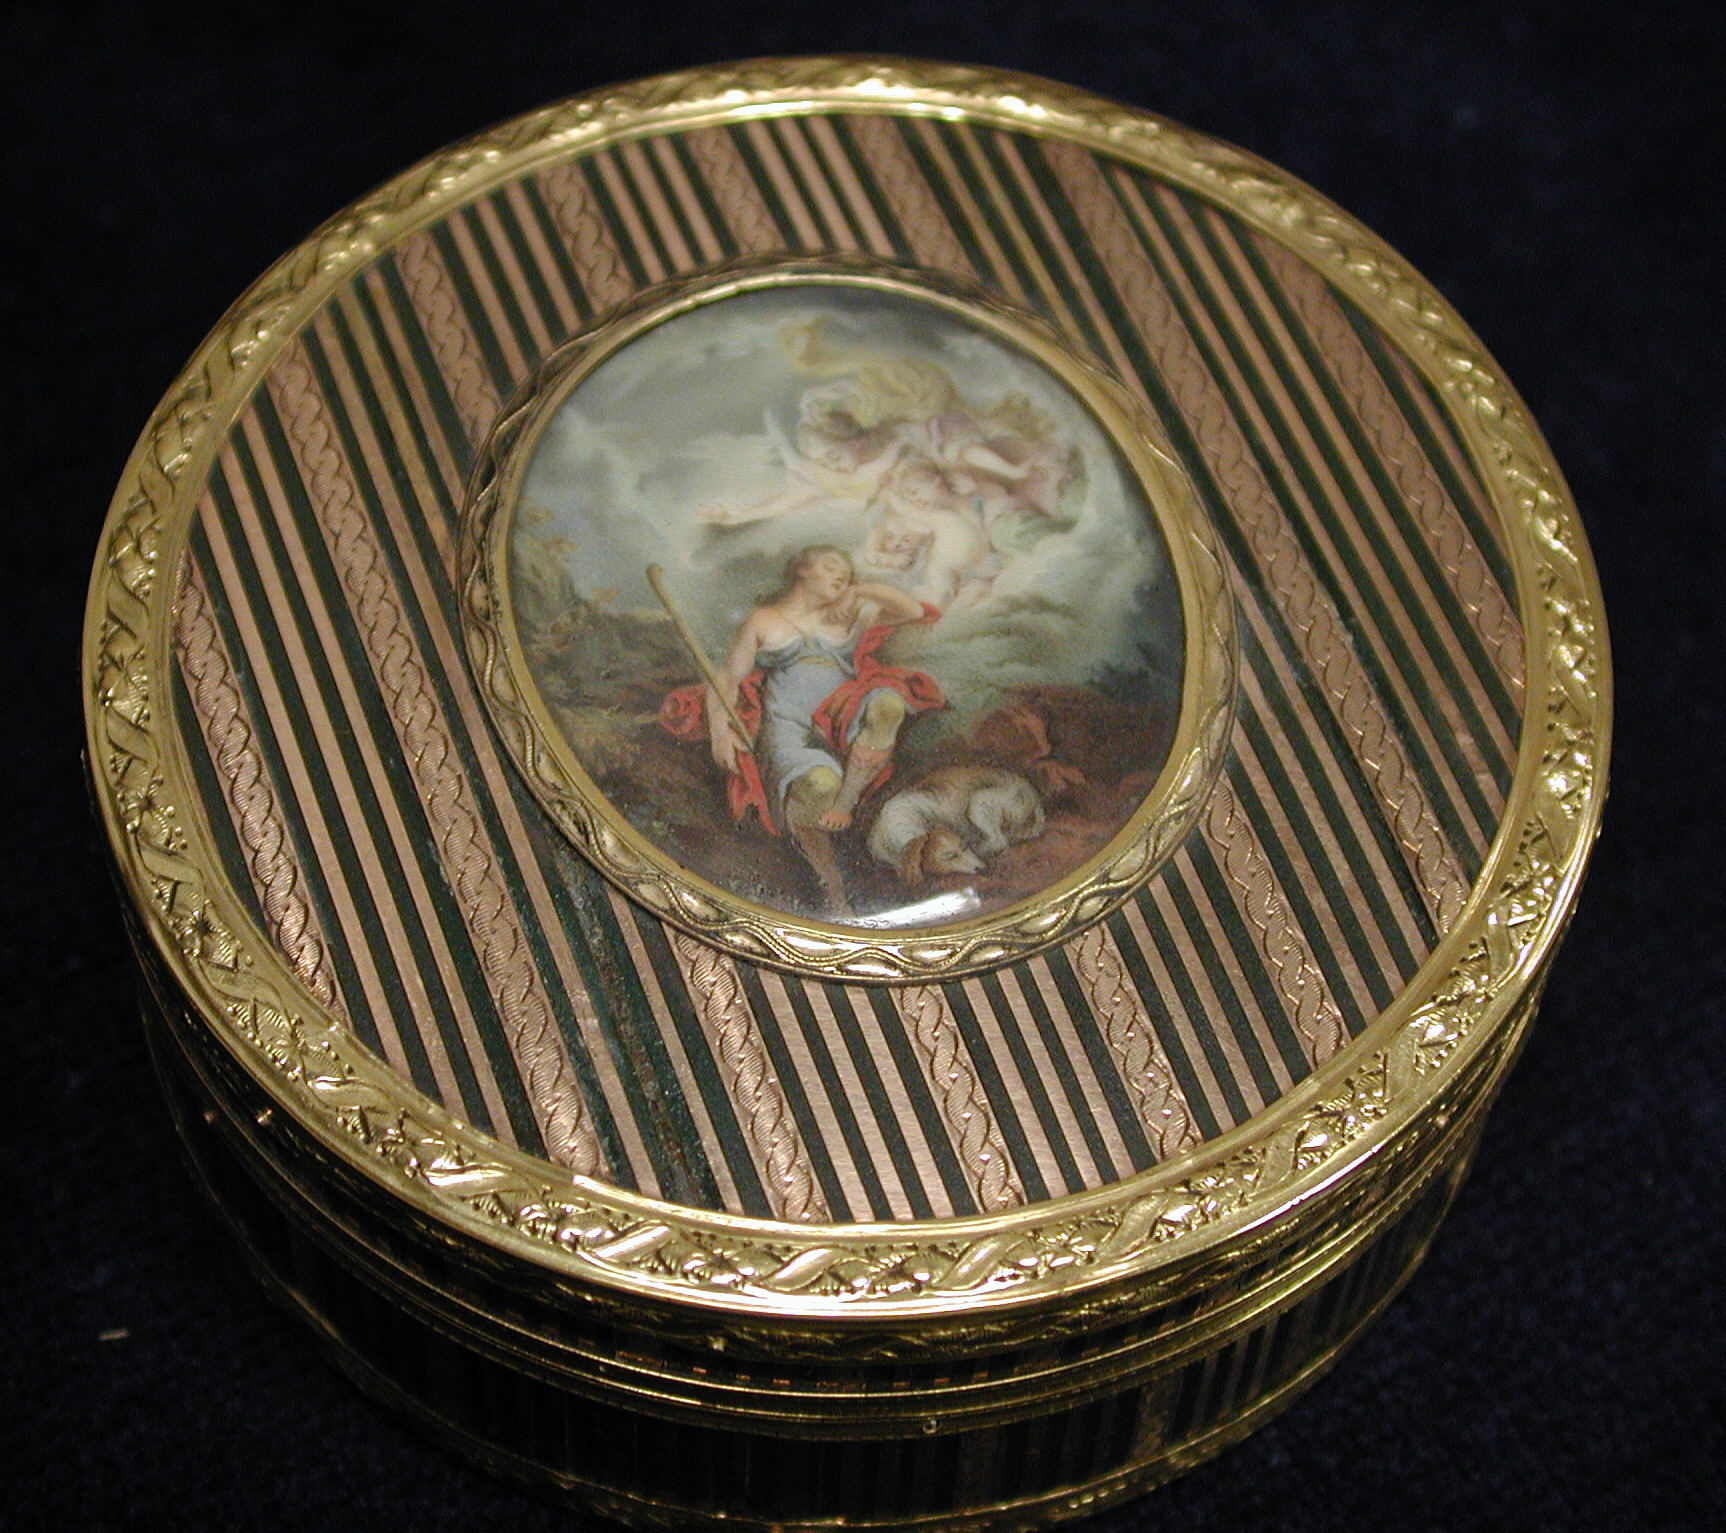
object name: snuffbox, painting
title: Snuffbox with miniature of sleeping Endymion and Selene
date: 1772-1773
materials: gold, ivory, shell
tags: sleeping,men,dogs